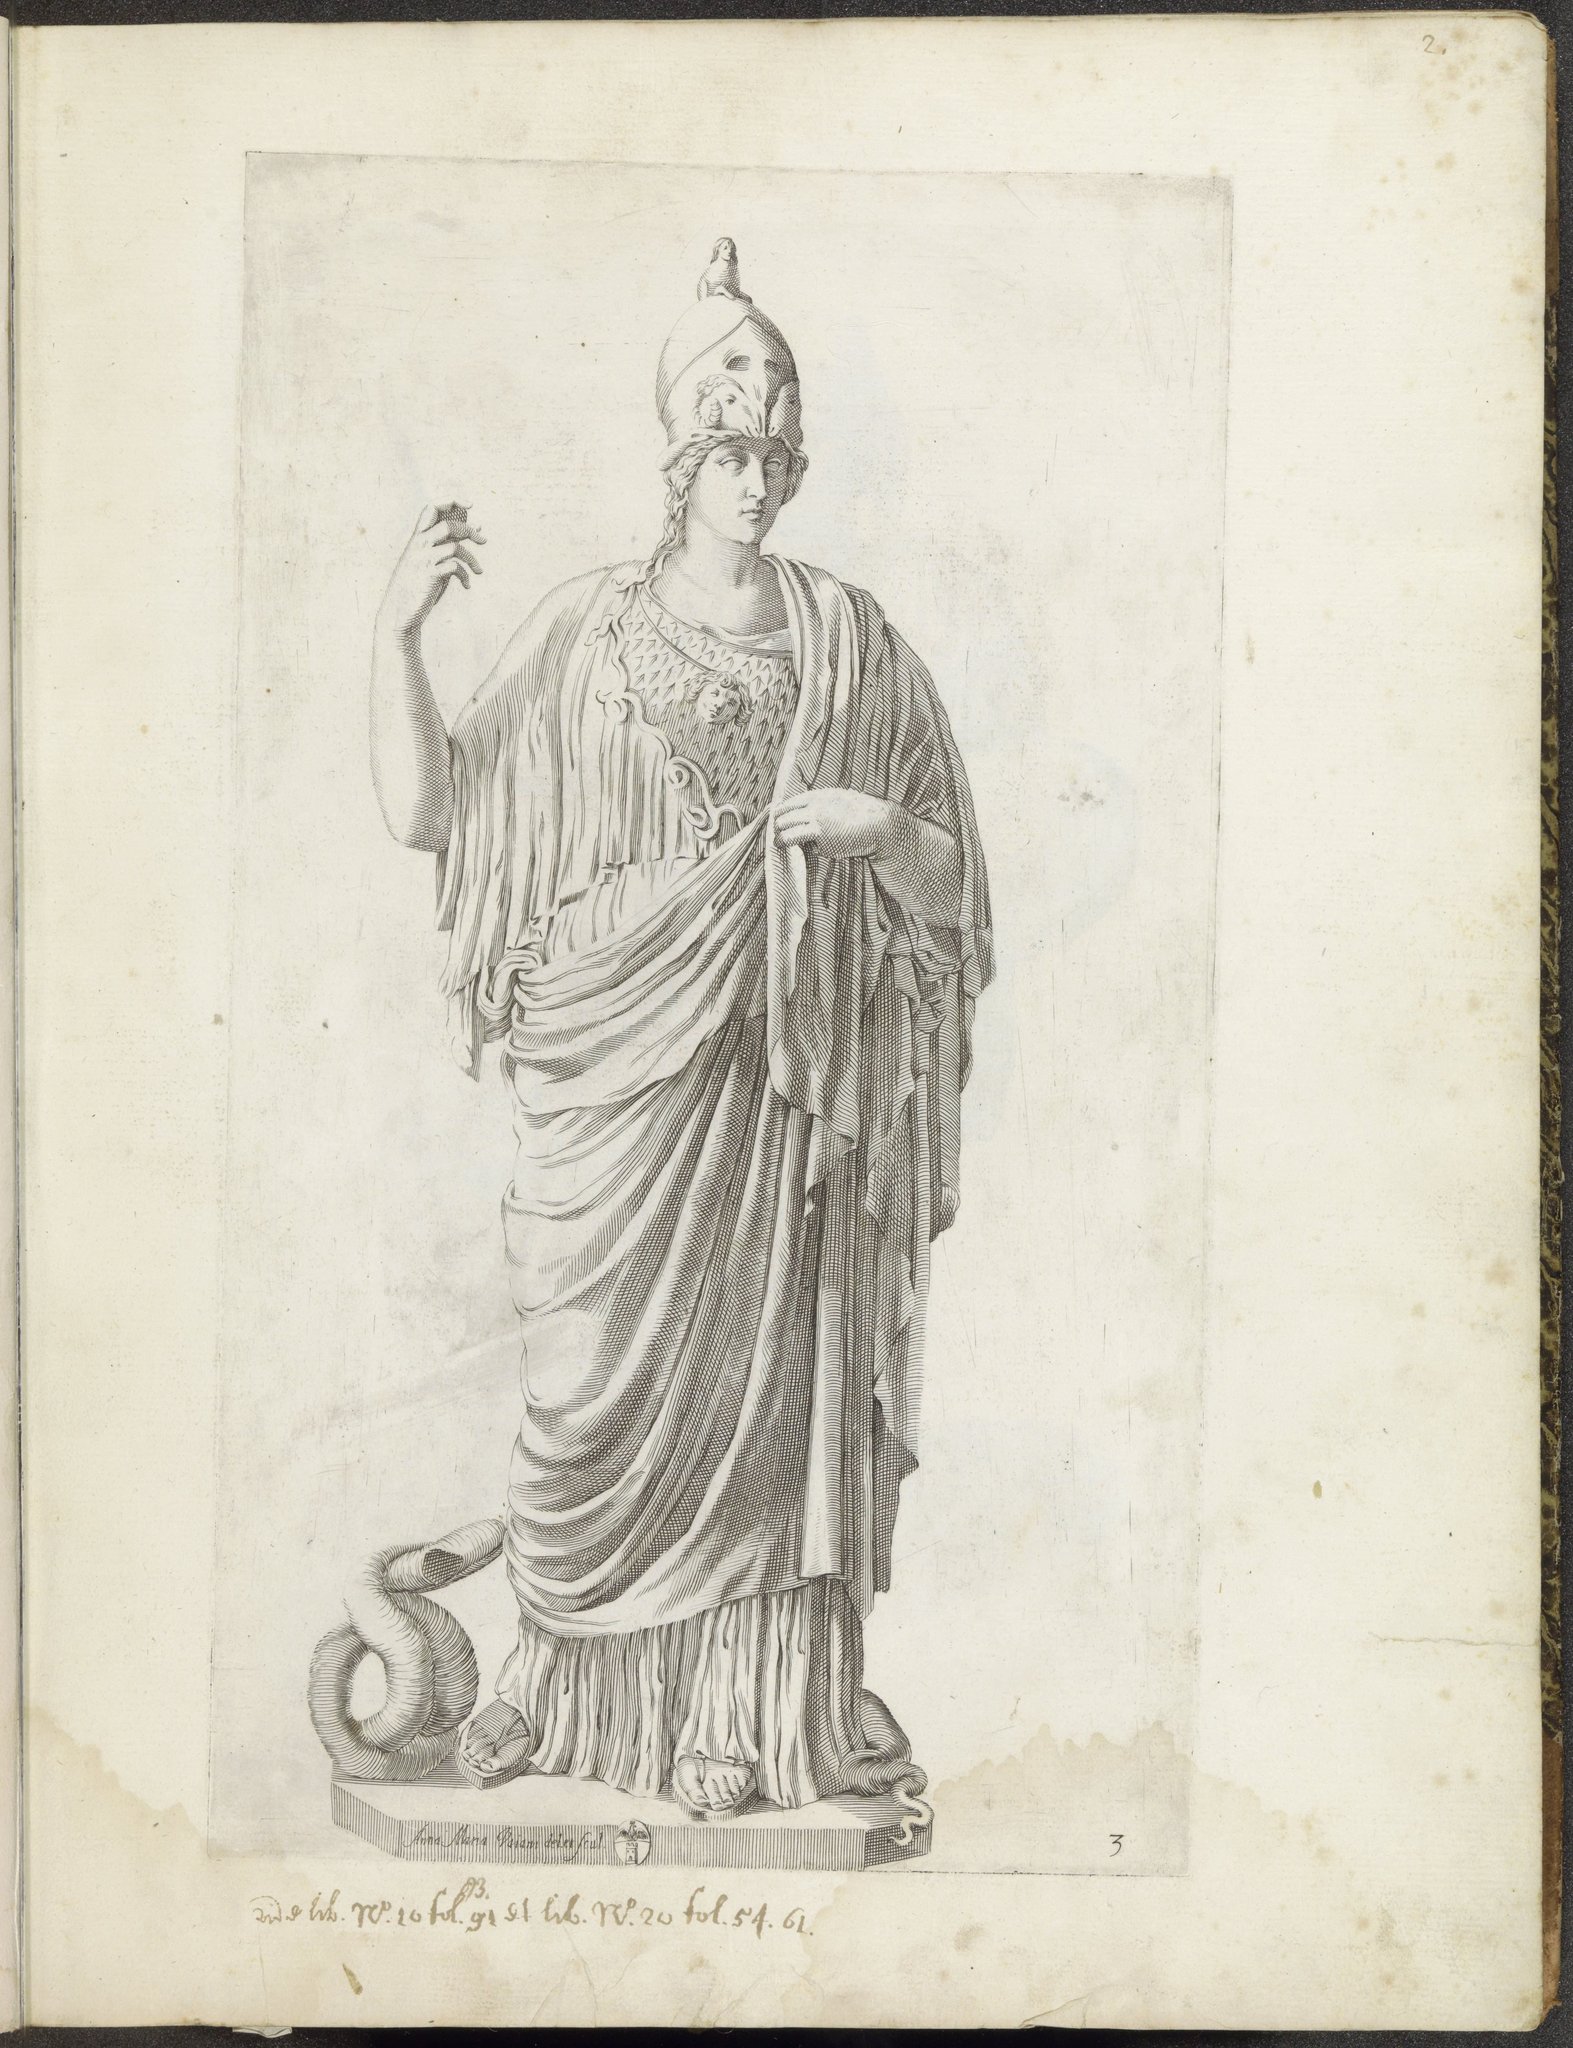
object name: album leaf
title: Standbeeld van Minerva (Athena Giustiniani)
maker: anna maria vaiani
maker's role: painter, print maker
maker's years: -1655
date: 1636-1647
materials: paper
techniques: engraving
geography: rome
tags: (story of) minerva (pallas, athena), piece of sculpture, reproduction of a piece of sculpture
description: Standbeeld van Minerva met helm op haar hoofd. Om haar hals de Medusakop. Midden onder op de basis het wapenschild van Vincenzo Giustiniani. Prent maakt deel uit van een album met een serie prenten naar de sculpturen in de verzameling in de Galleria Giustiniani te Rome.